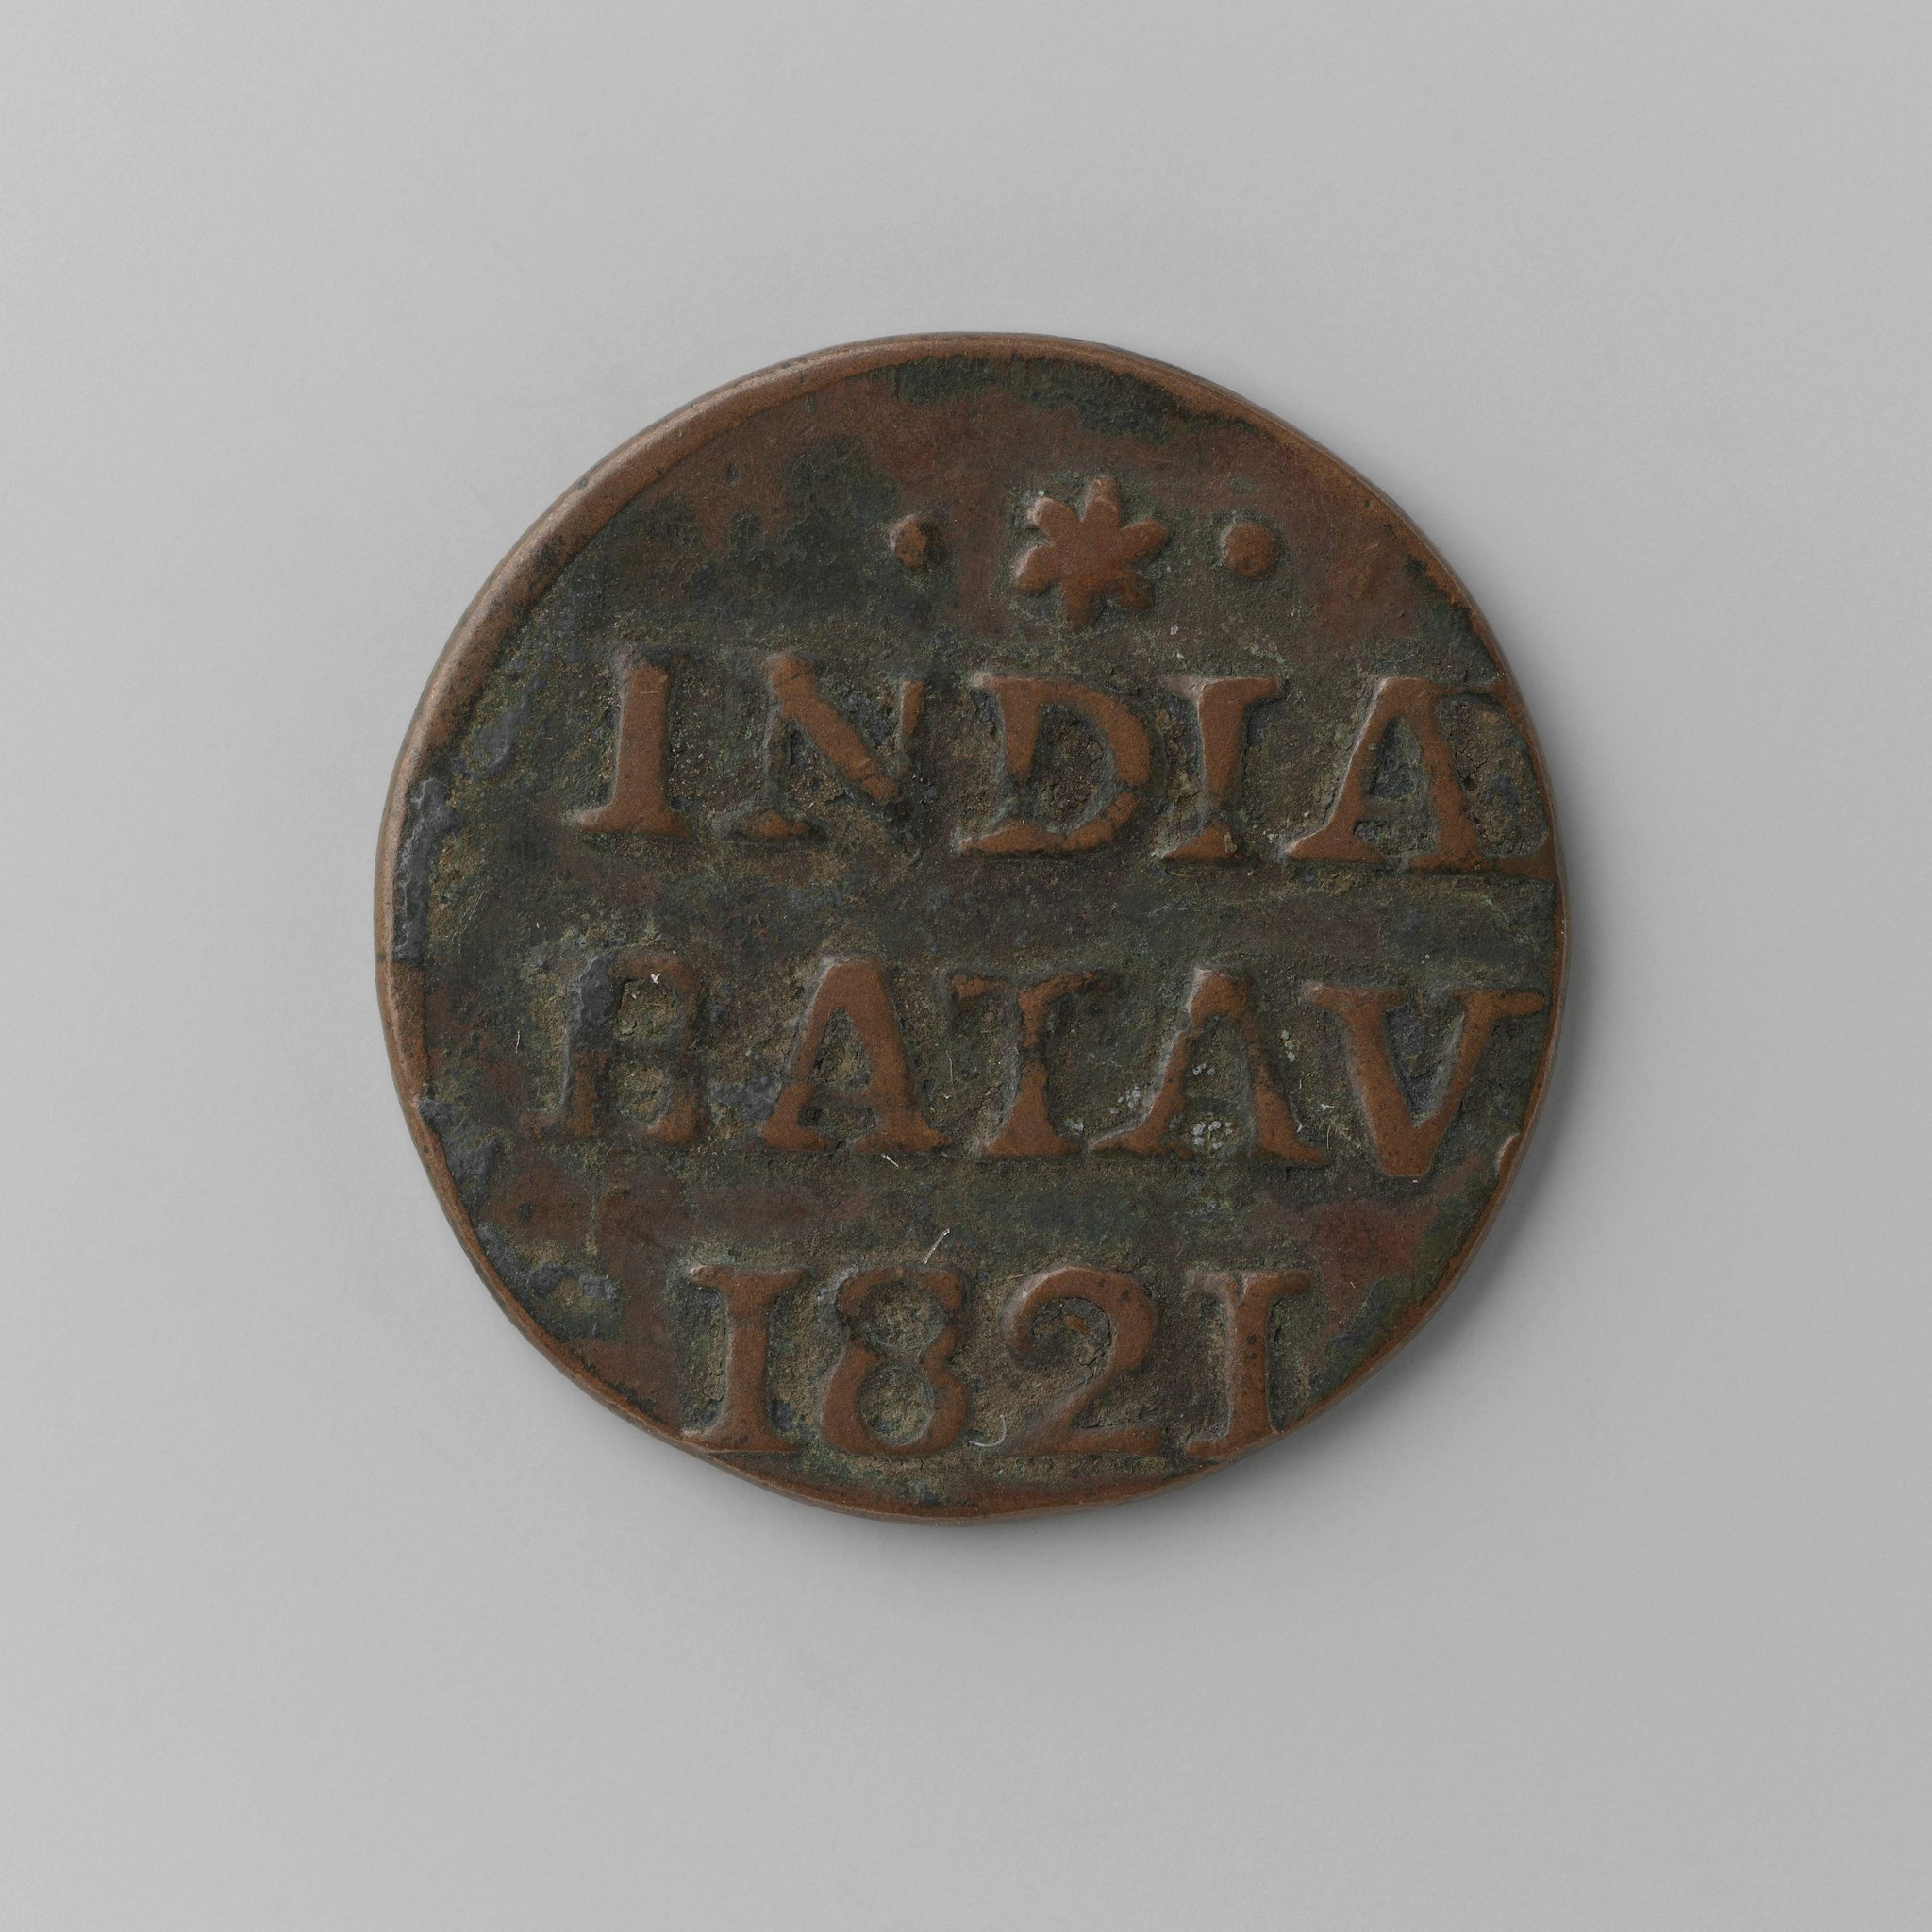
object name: coin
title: Duit van Nederlands Indië,1821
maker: william i of the netherlands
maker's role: koning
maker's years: 1772-1843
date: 1821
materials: copper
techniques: striking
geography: surabaya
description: Koperen munt. Voorzijde: tussen waarde-aanduiding 5 1/16 G. gekroond generaliteitswapenschild. Keerzijde: tweeregelig opschrift, waarboven muntteken en waaronder jaartal. Gladde rand.